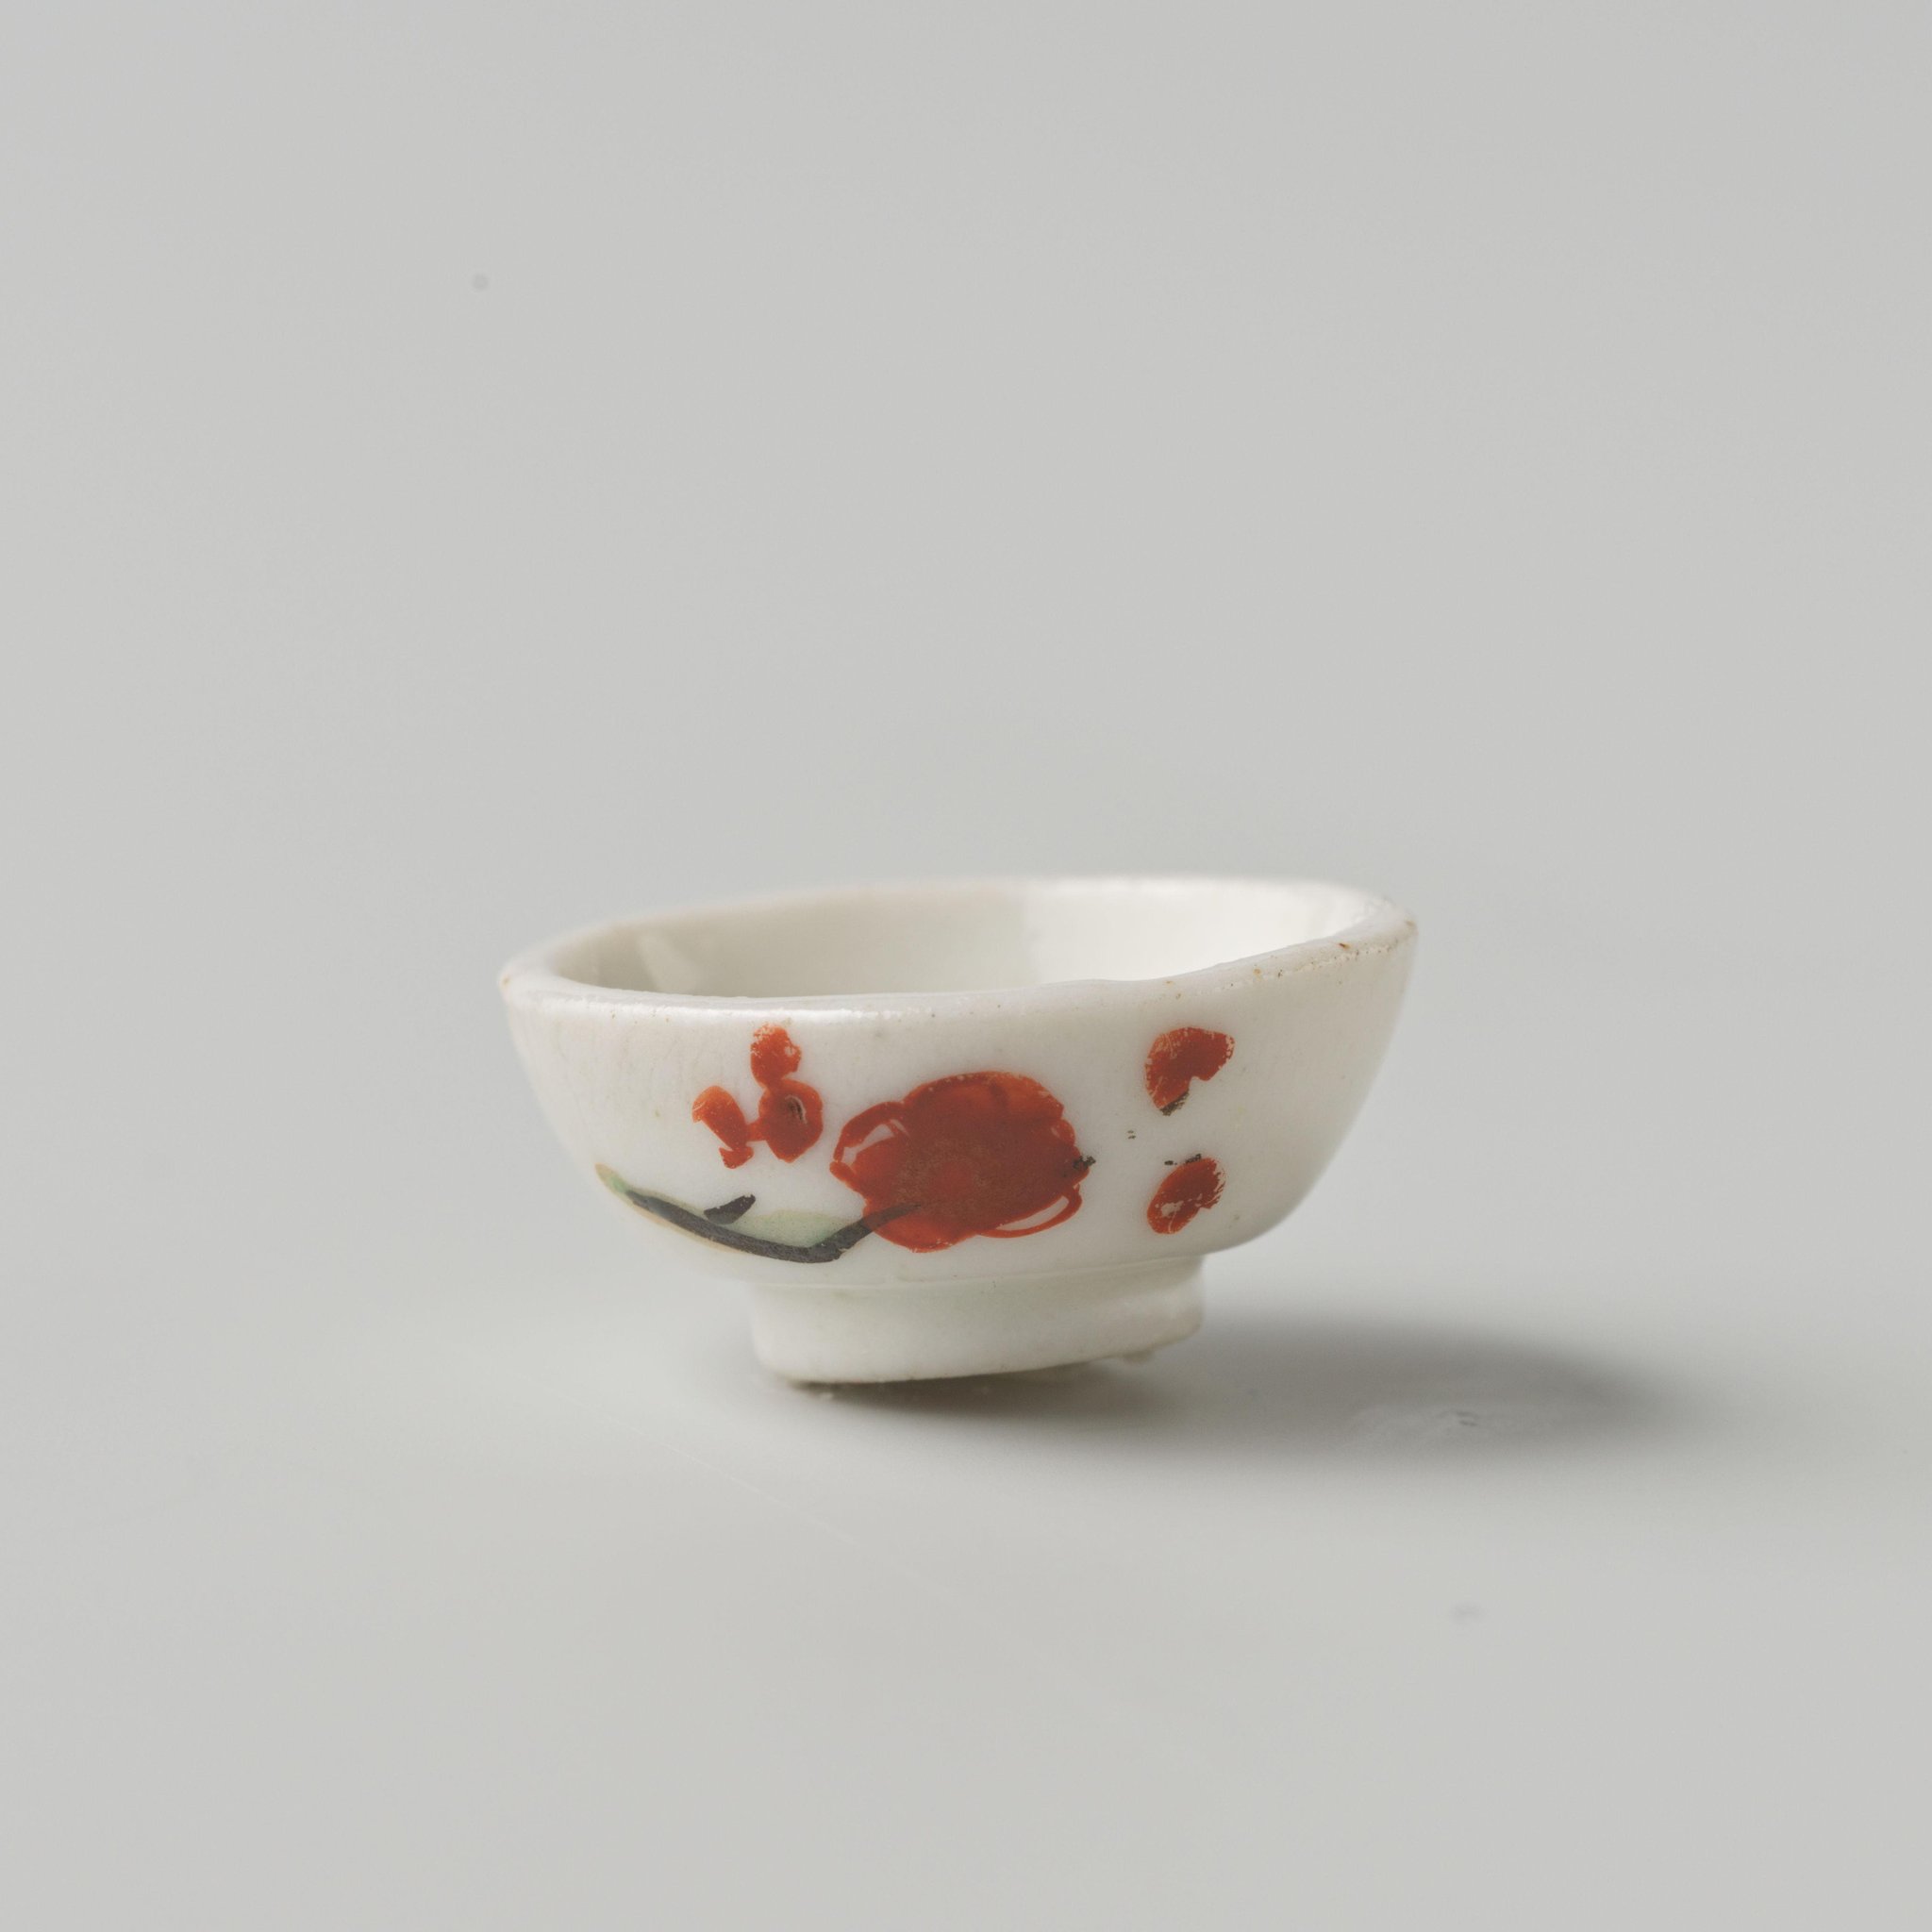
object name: bowl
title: Kom van porselein met veelkleurige decoratie in Kakiemonstijl, bloesemtak op buitenzijde kom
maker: Anonymous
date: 1690-1710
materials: porcelain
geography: arita